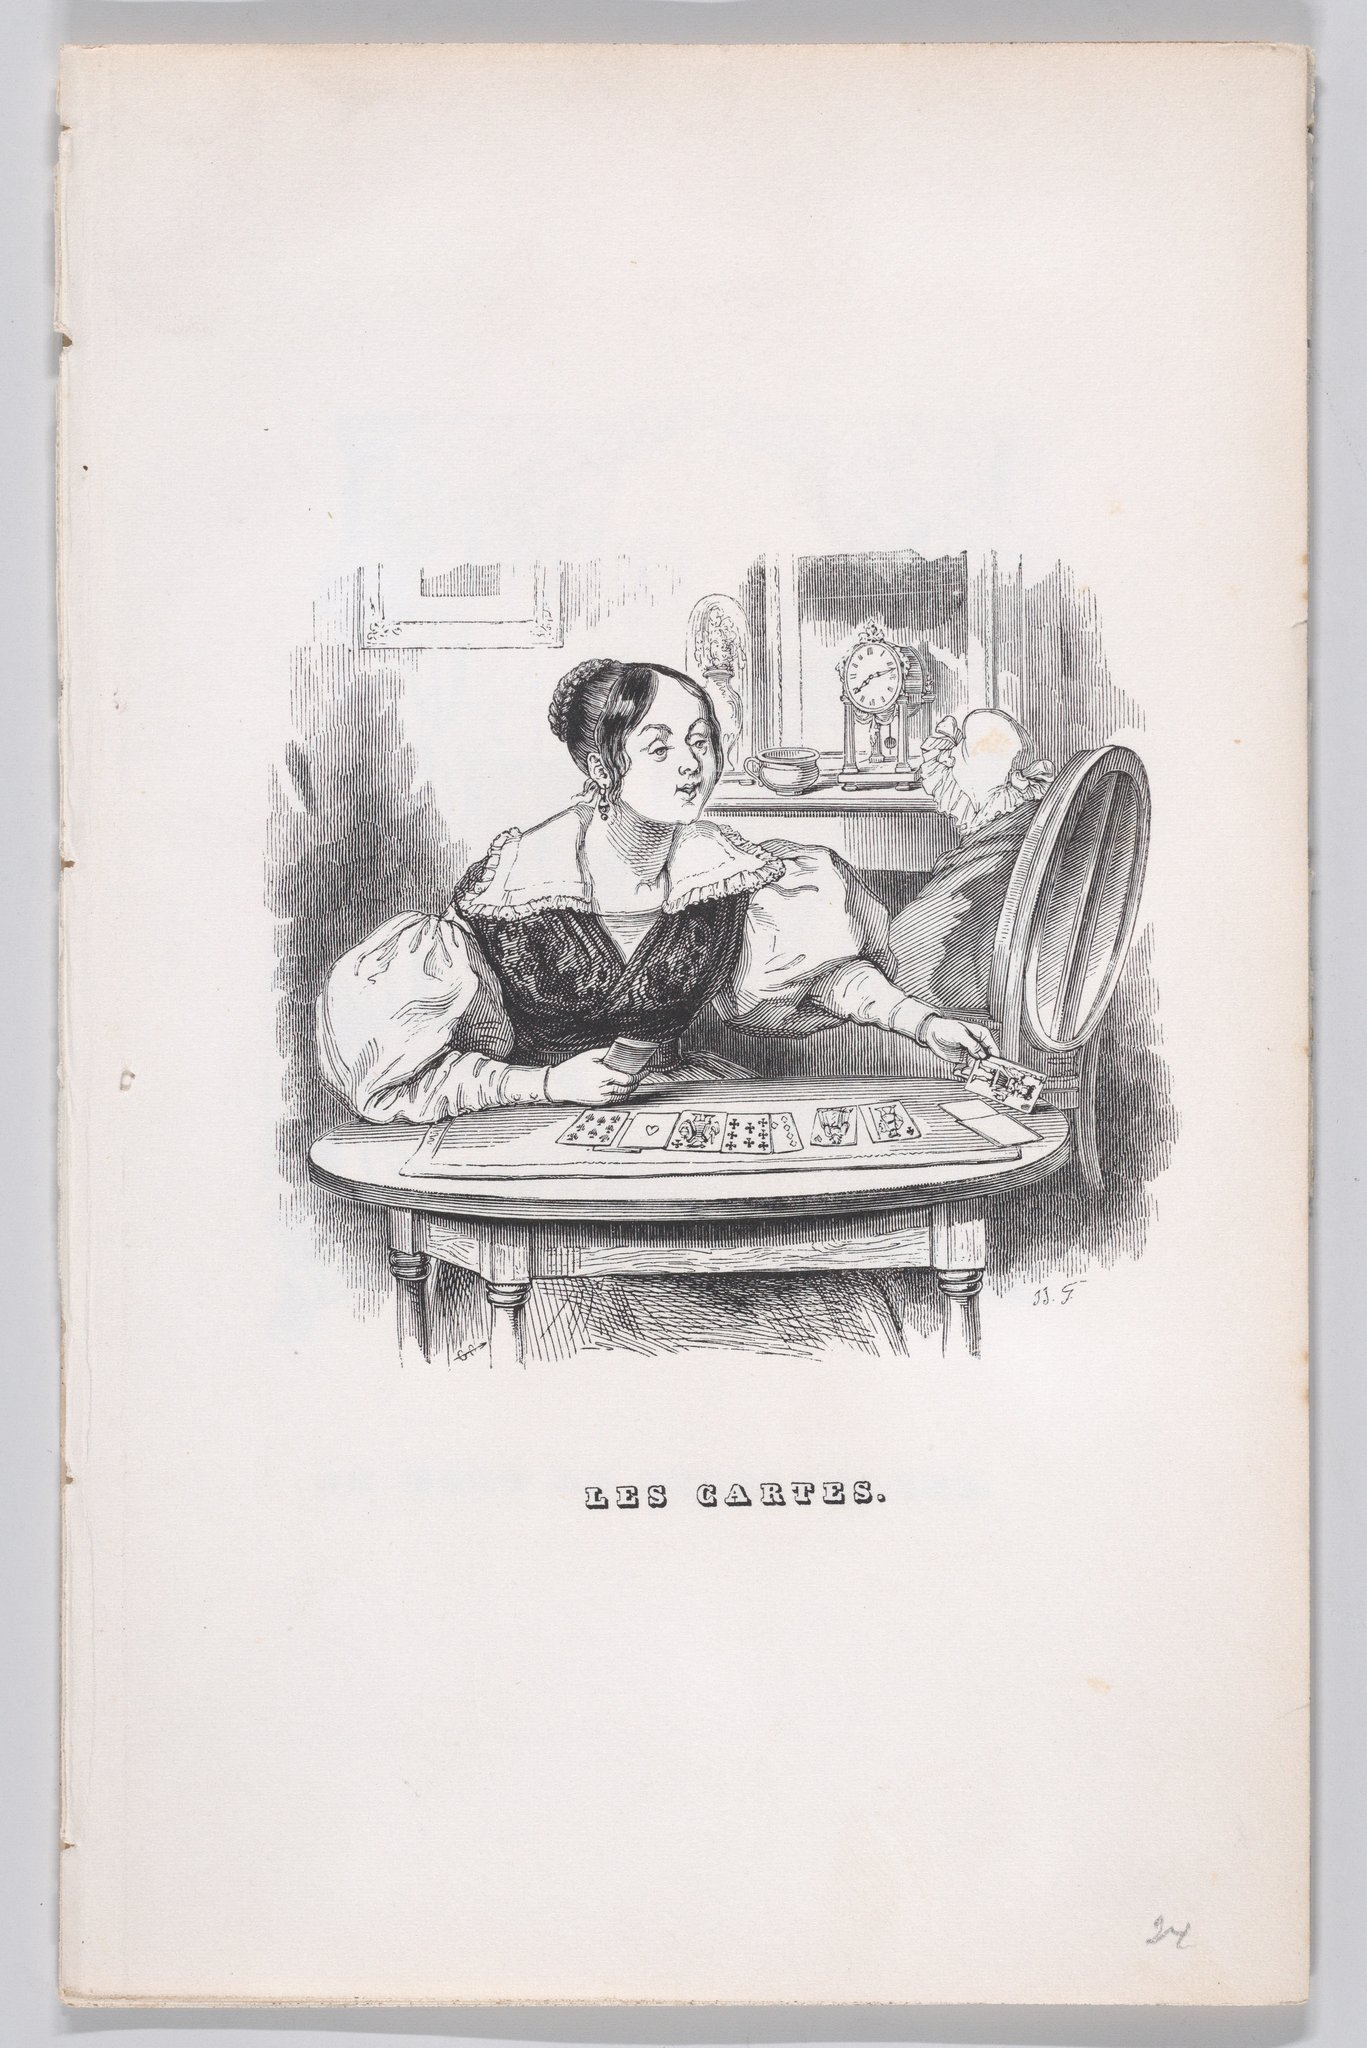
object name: print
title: The Cards, from "The Complete Works of Béranger"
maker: j. j. grandville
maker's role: artist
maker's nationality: french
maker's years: 1803-1847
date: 1836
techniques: engraving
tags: women,playing cards,games